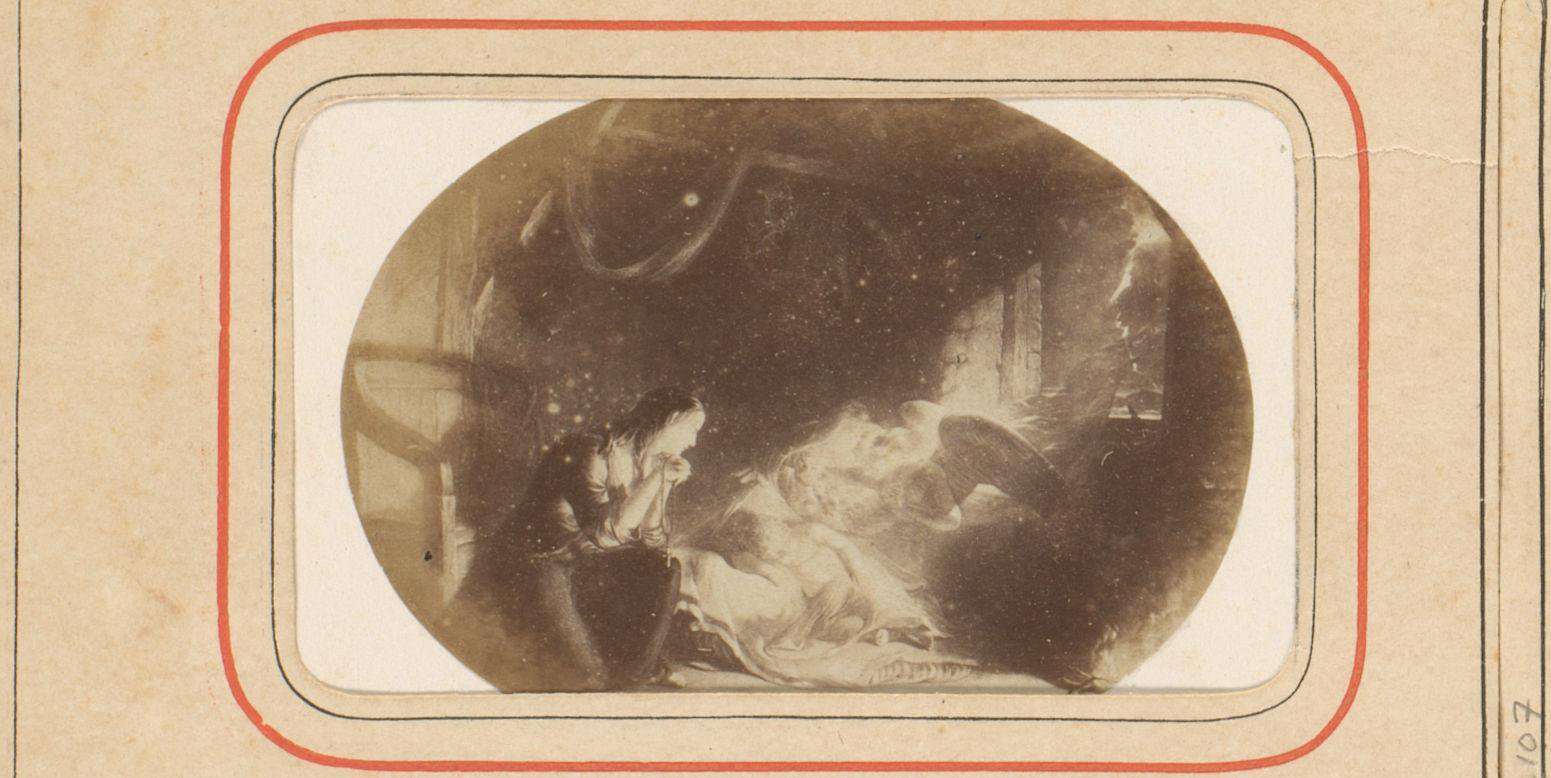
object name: photograph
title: Het kranke kind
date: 1870-1890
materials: cardboard, paper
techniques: albumen print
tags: patient, sick person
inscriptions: inscription: ‘Onder tranen en gebeden/ Houdt de moeder heel den nacht/ Bij het kranke kind de Wacht, (...)’